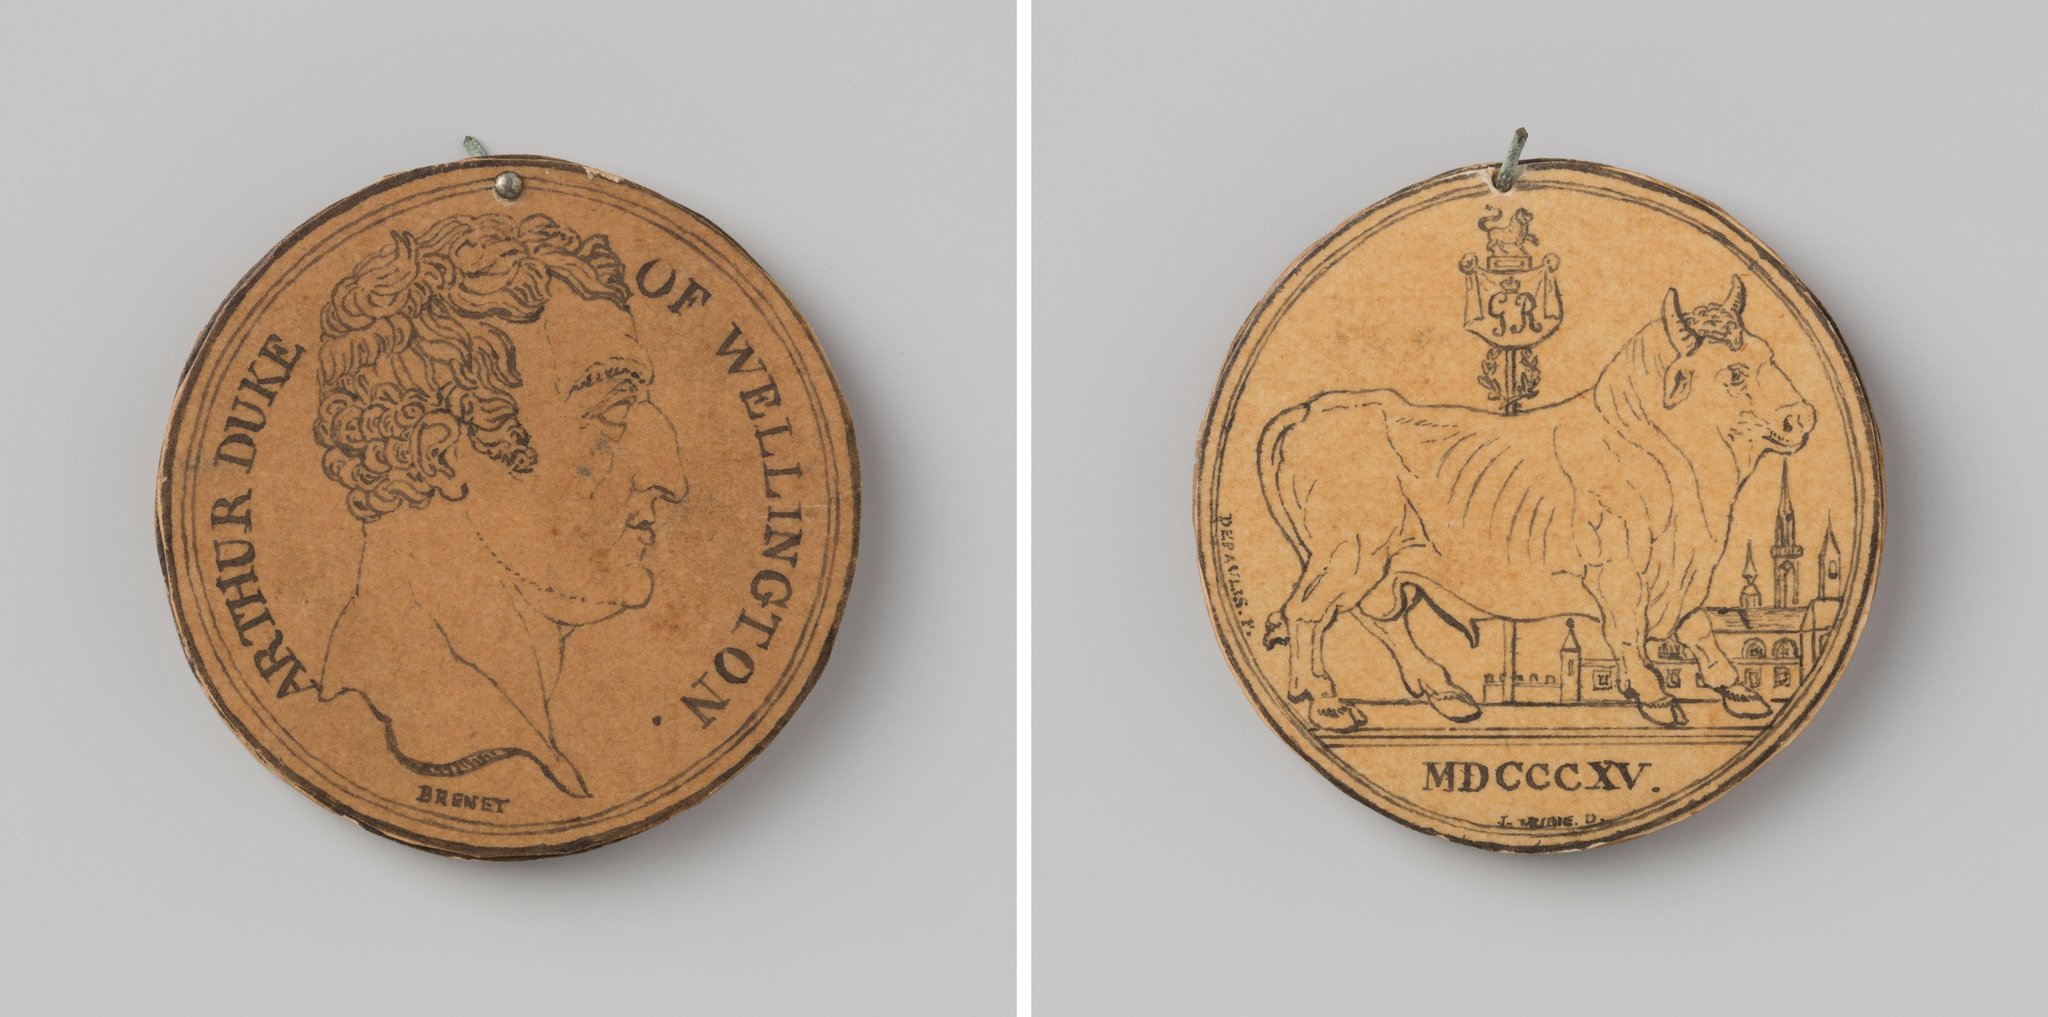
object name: medal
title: Inname van Parijs, ter ere van de hertog van Wellington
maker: nicolas guy antoine brenet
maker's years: 1773-1846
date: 1815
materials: cardboard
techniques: drawing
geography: england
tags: walmer castle, arthur wellesley of wellington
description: Voorzijde: borststuk man binnen omschrift. Keerzijde: gezicht op Louvre binnen omschrift; afsnede: opschrift